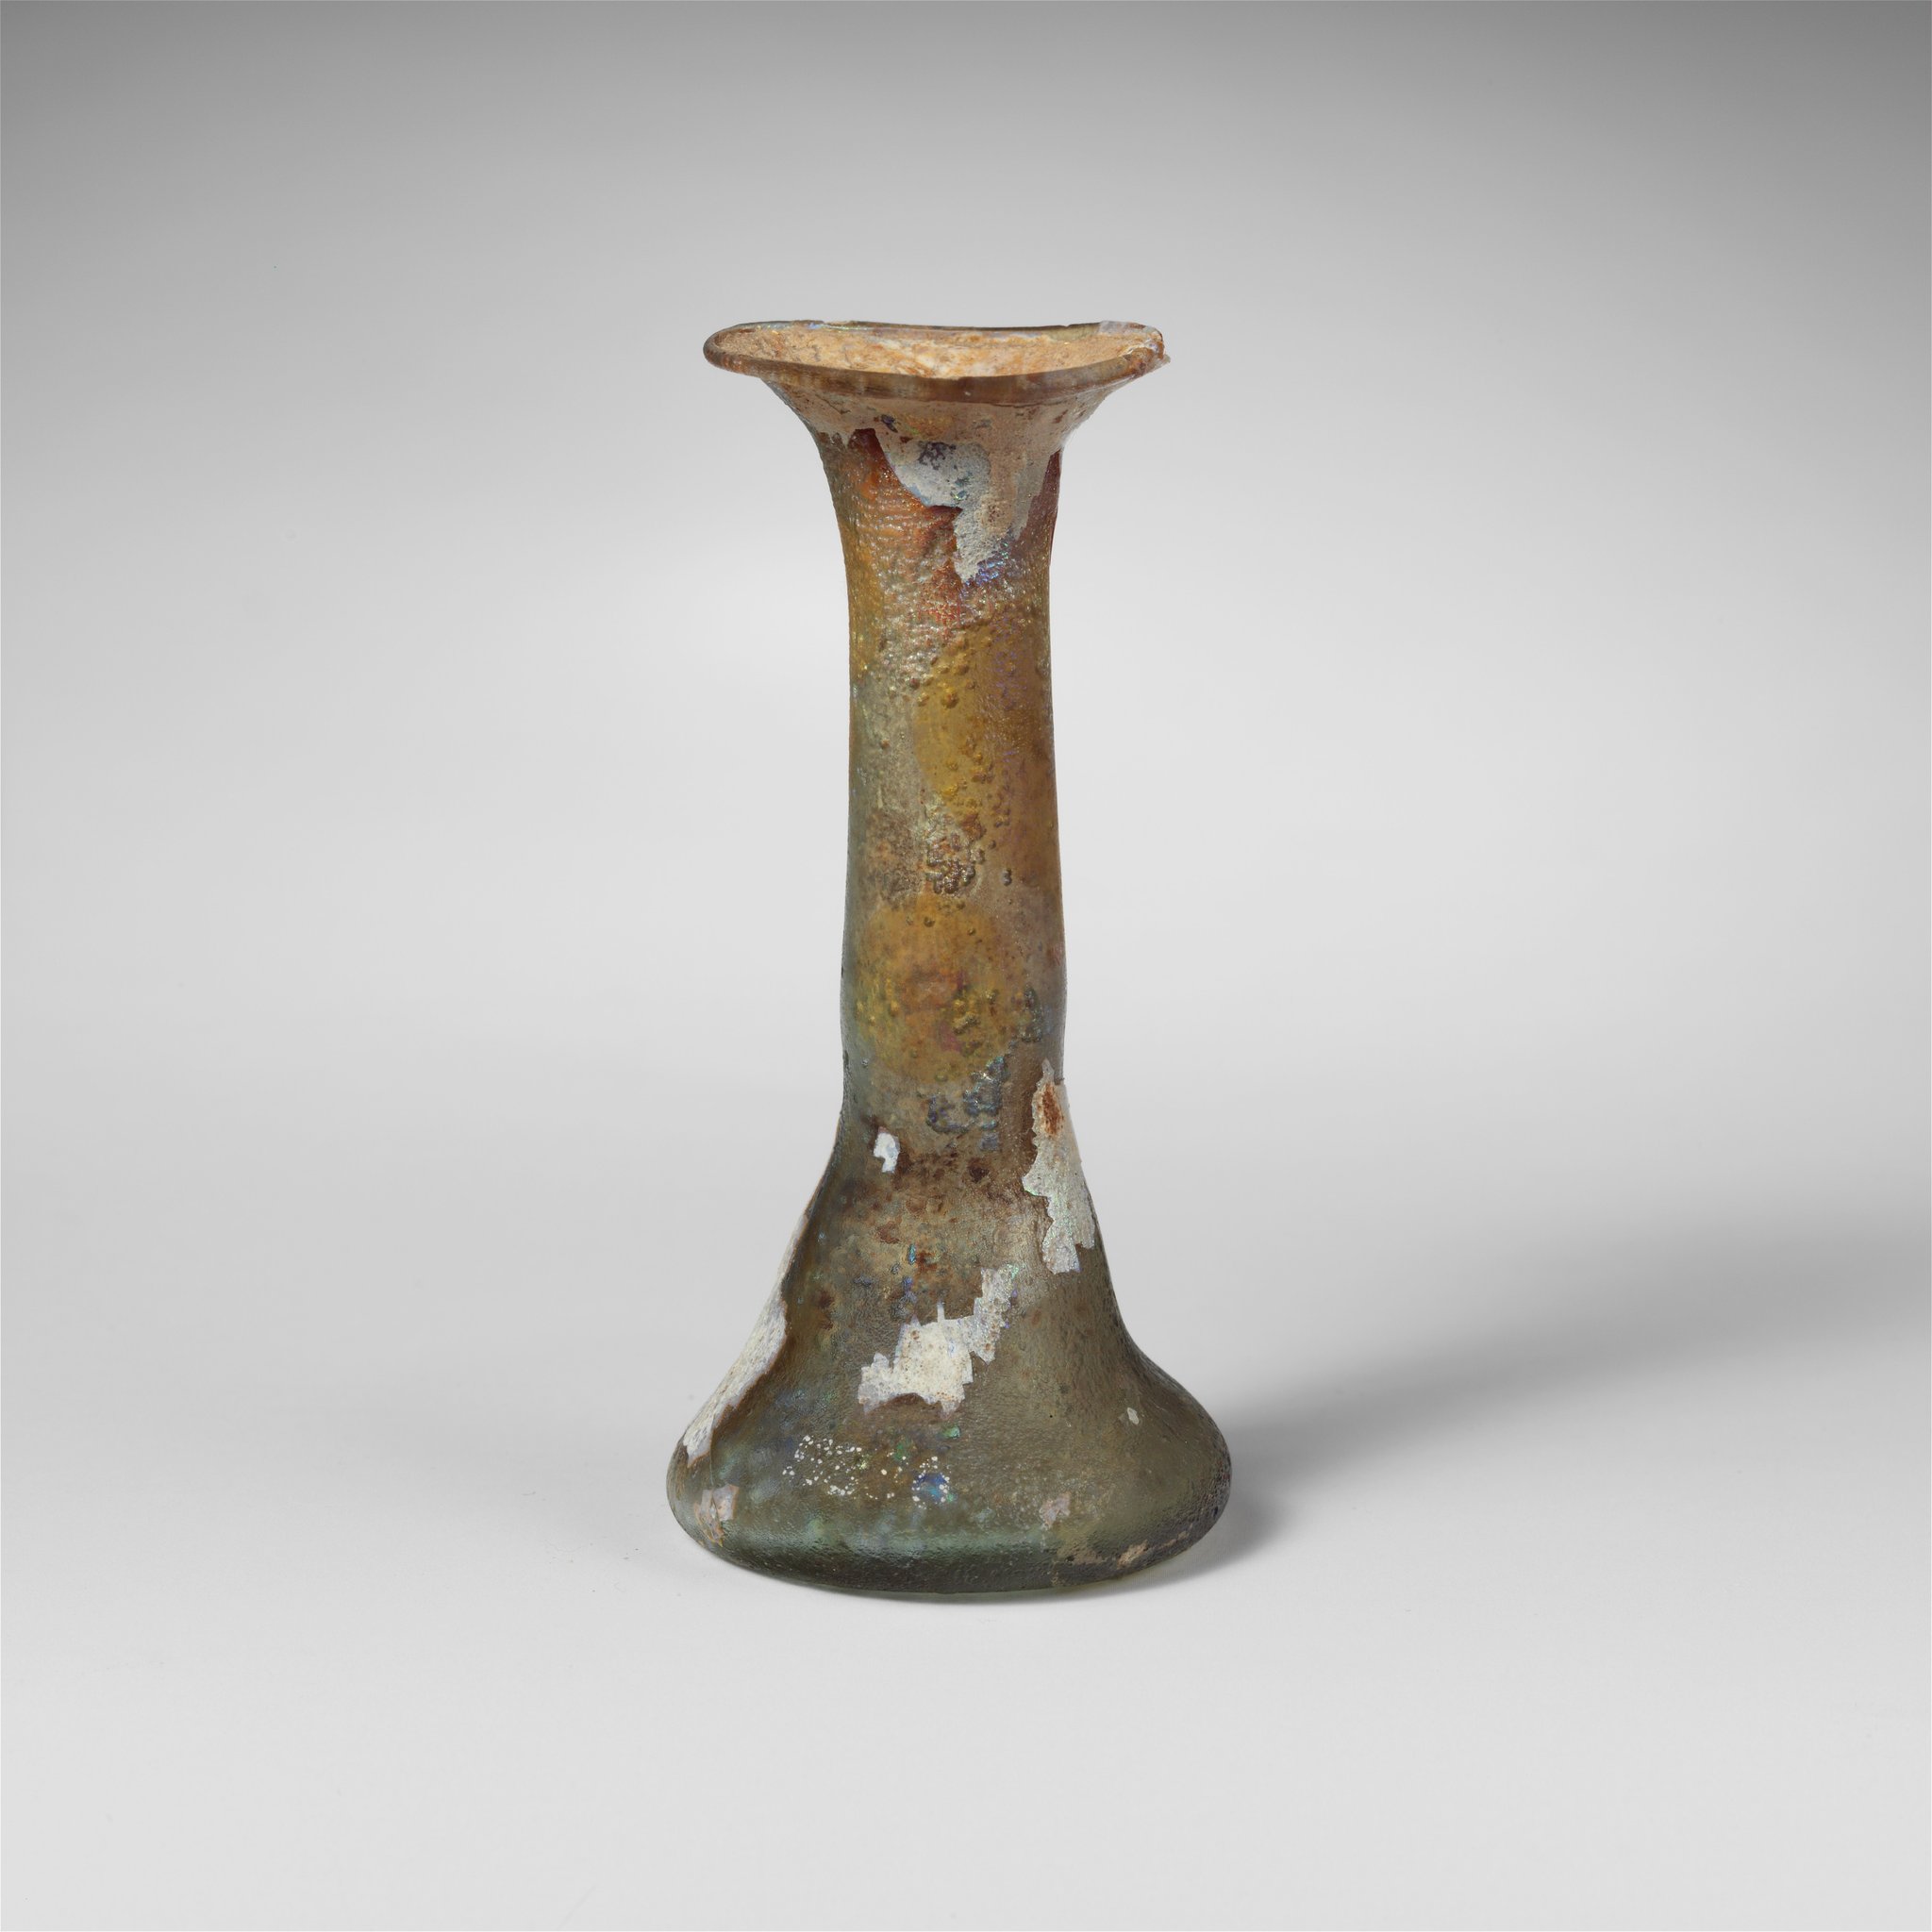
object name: perfume bottle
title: Glass perfume bottle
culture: roman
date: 67-300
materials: glass